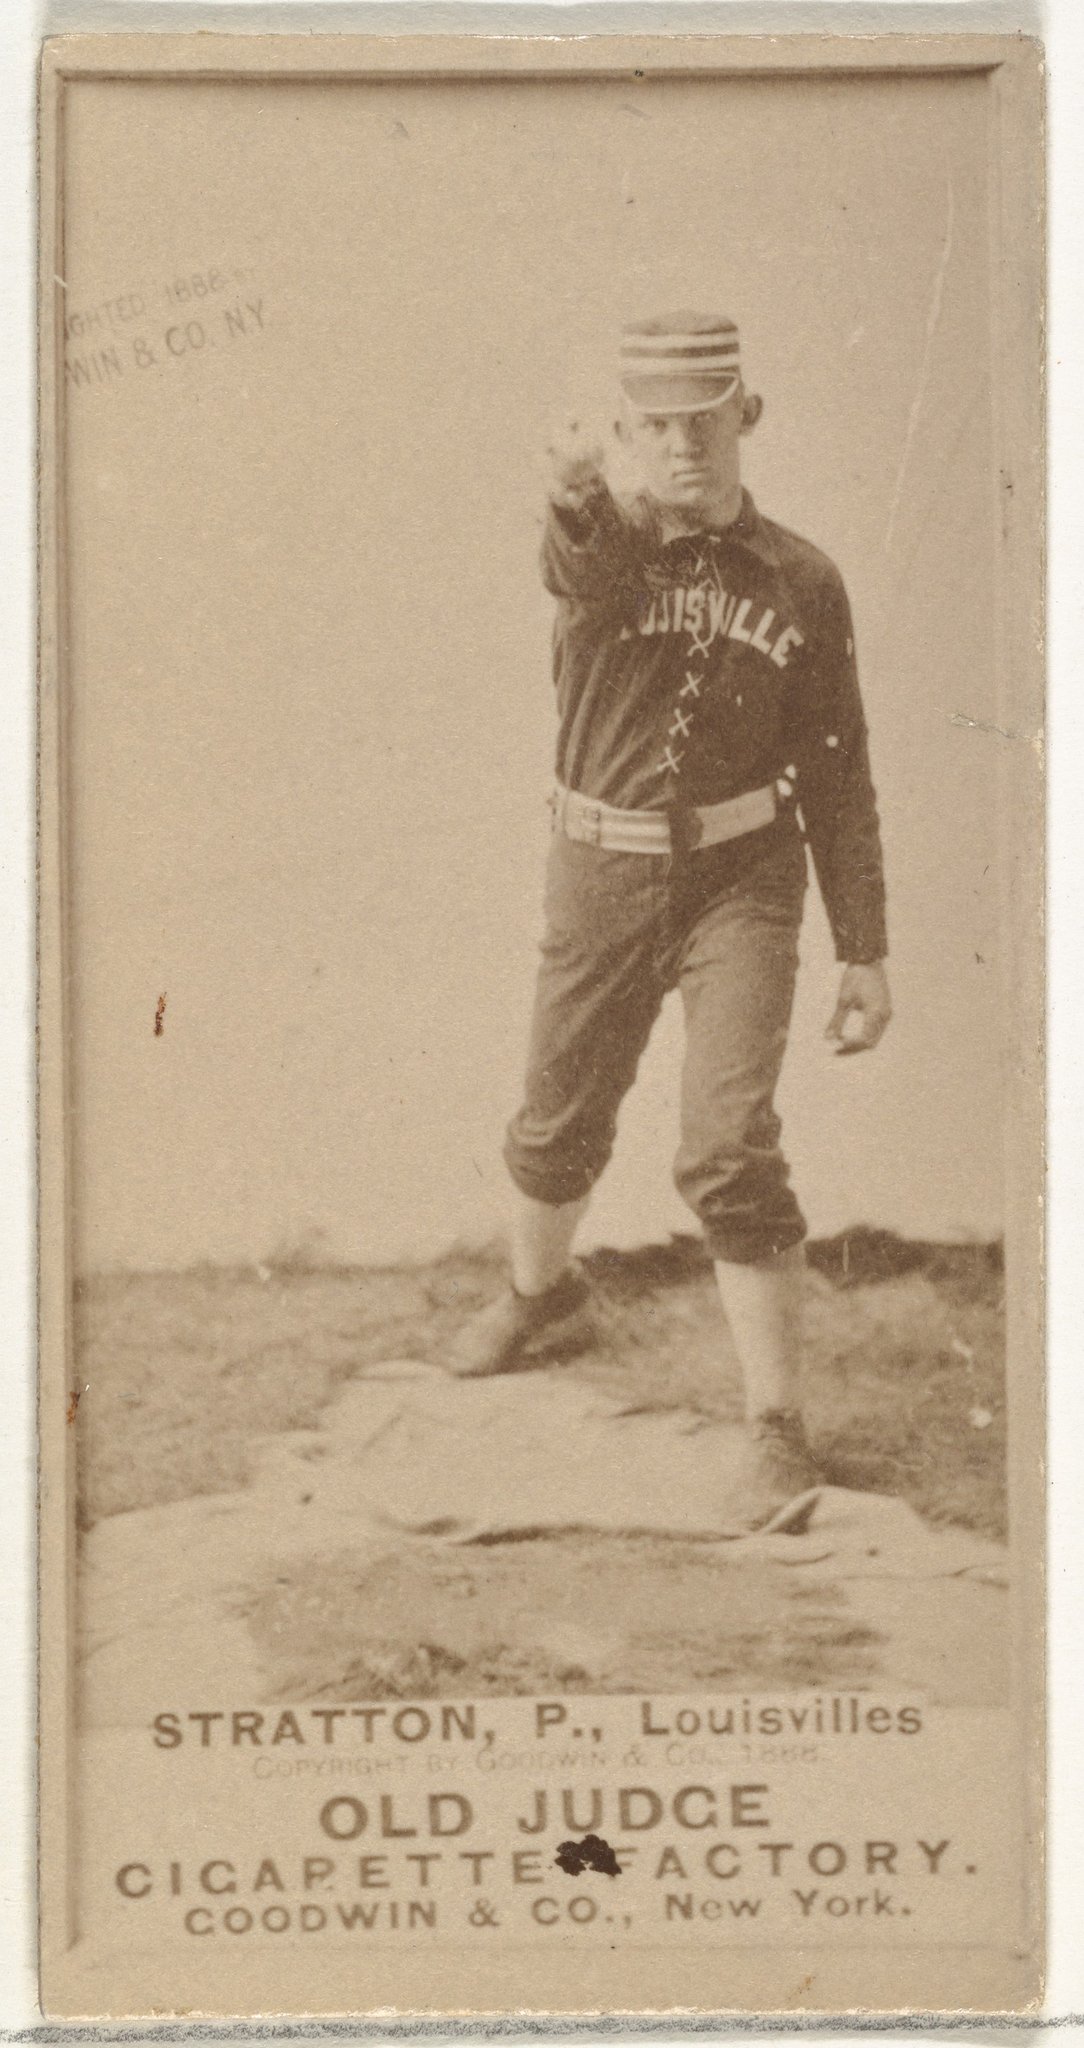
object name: baseball card, photograph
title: Chilton Scott Stratton, Pitcher, Louisville Colonels, from the Old Judge series (N172) for Old Judge Cigarettes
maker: goodwin & company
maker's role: publisher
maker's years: 1850-1950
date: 1888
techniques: albumen silver print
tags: men,portraits,baseball,athletes